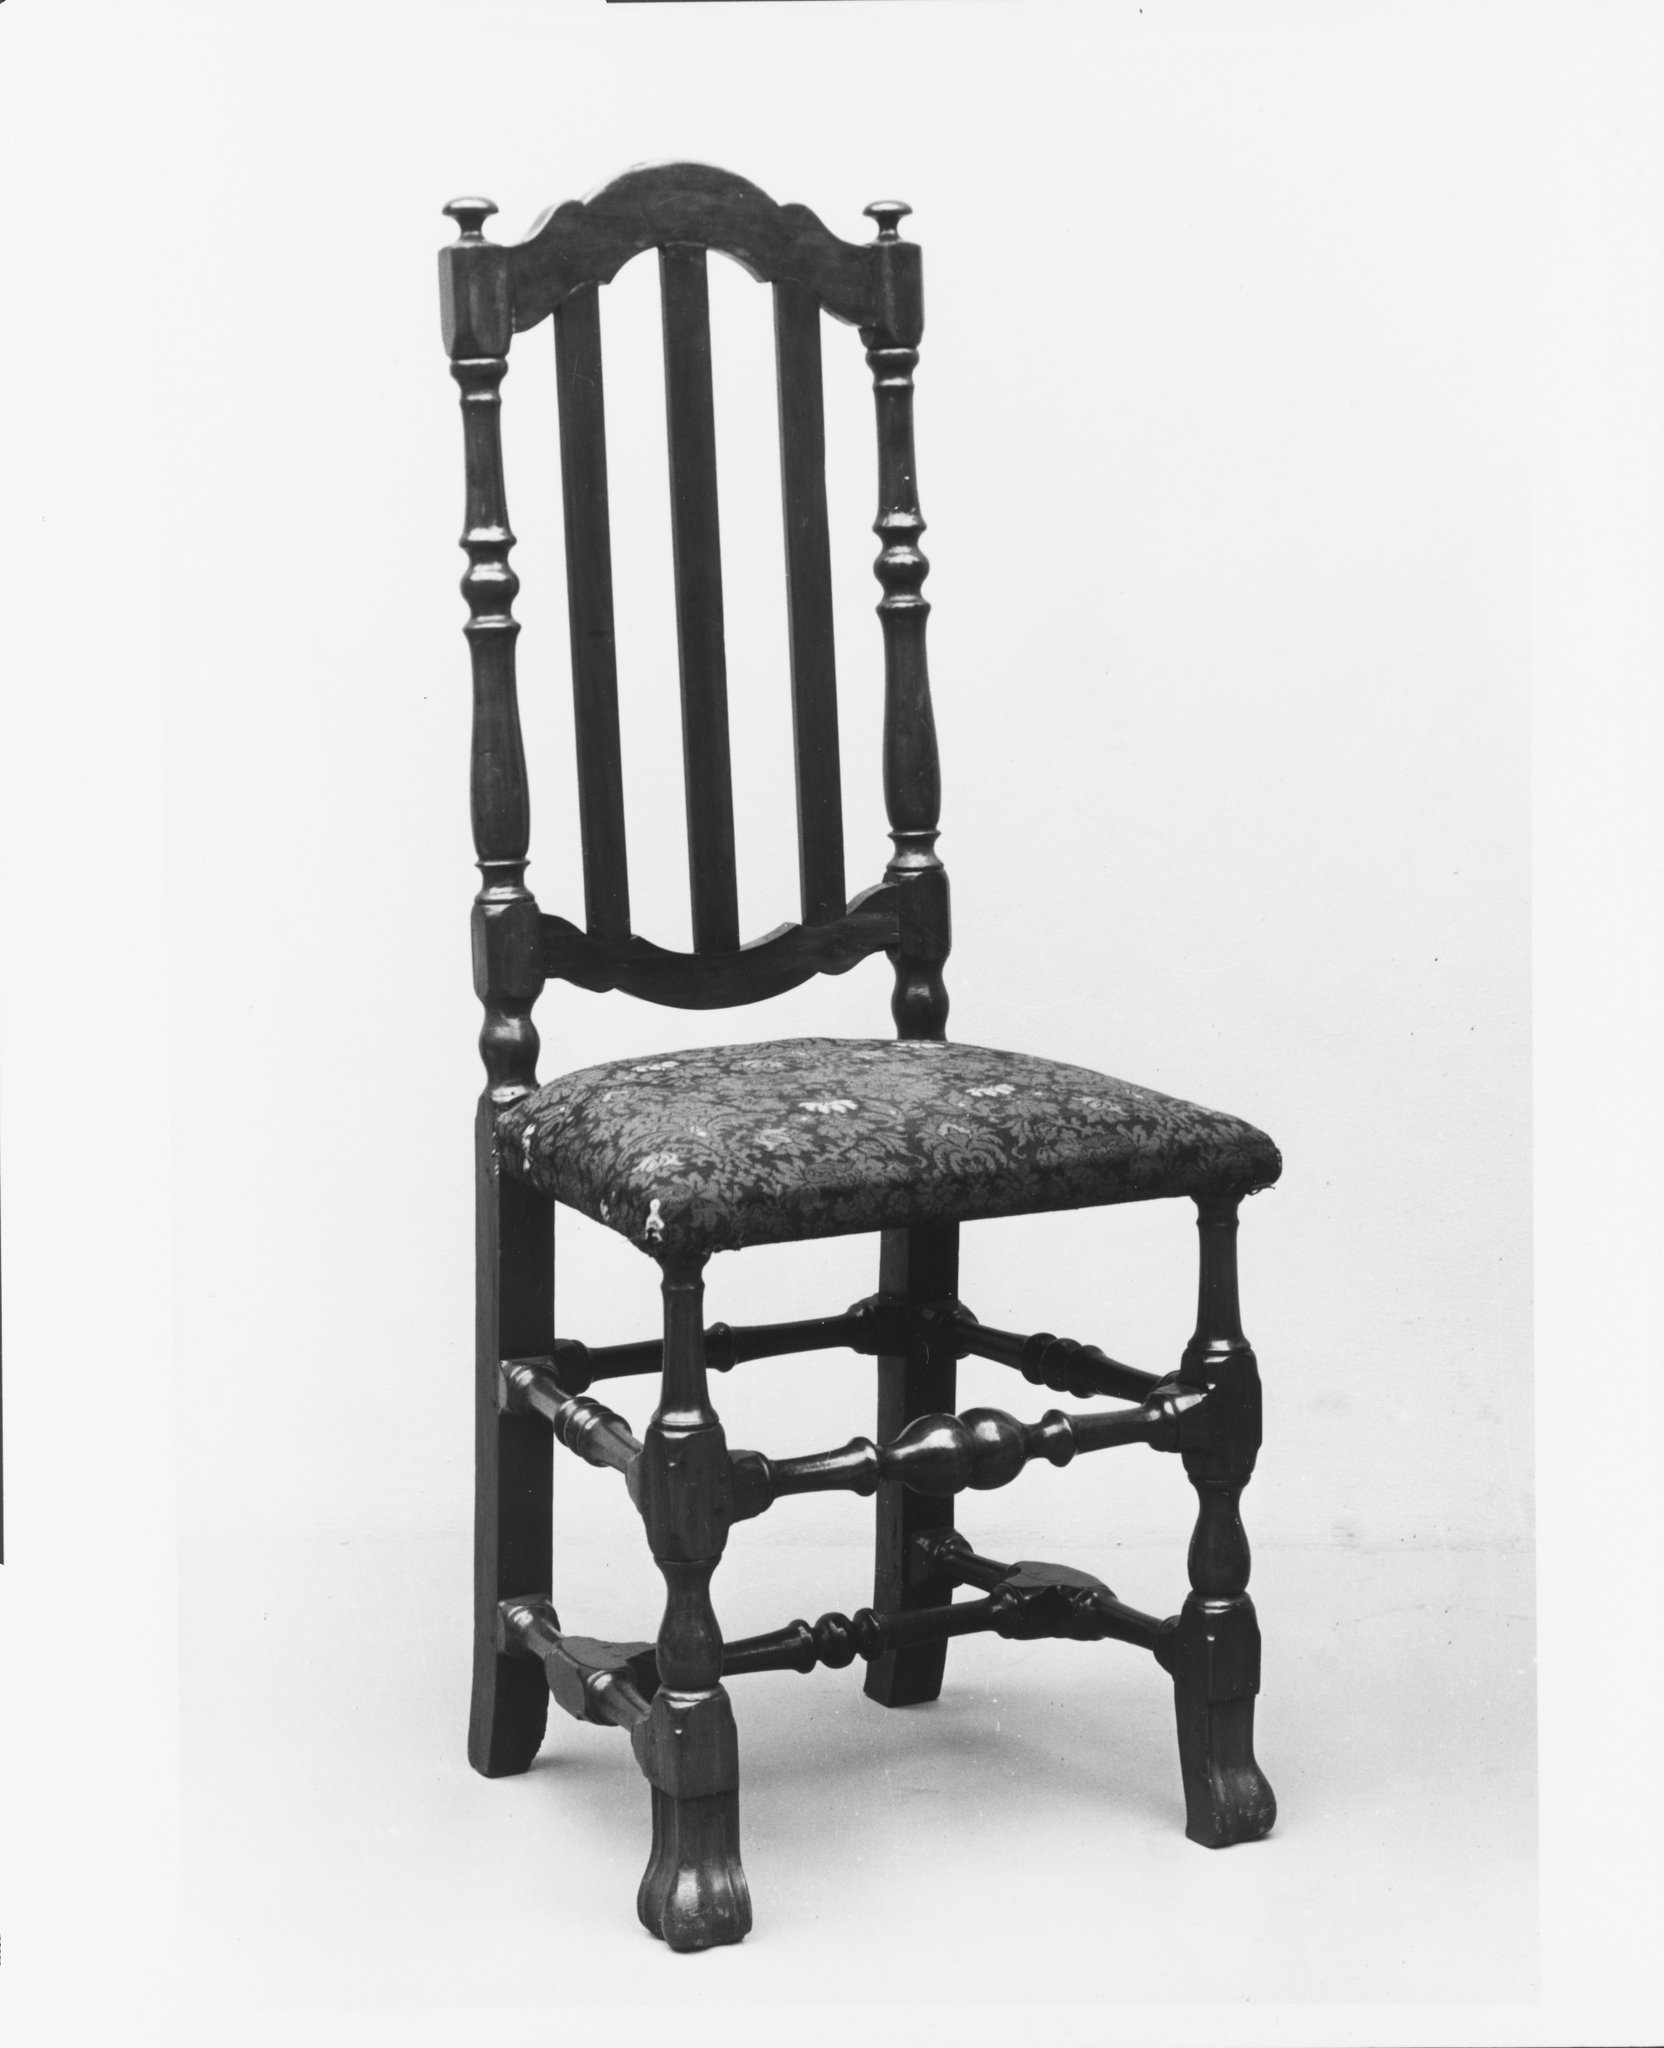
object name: side chair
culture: bermudian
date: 1700-1725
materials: wood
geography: bermuda